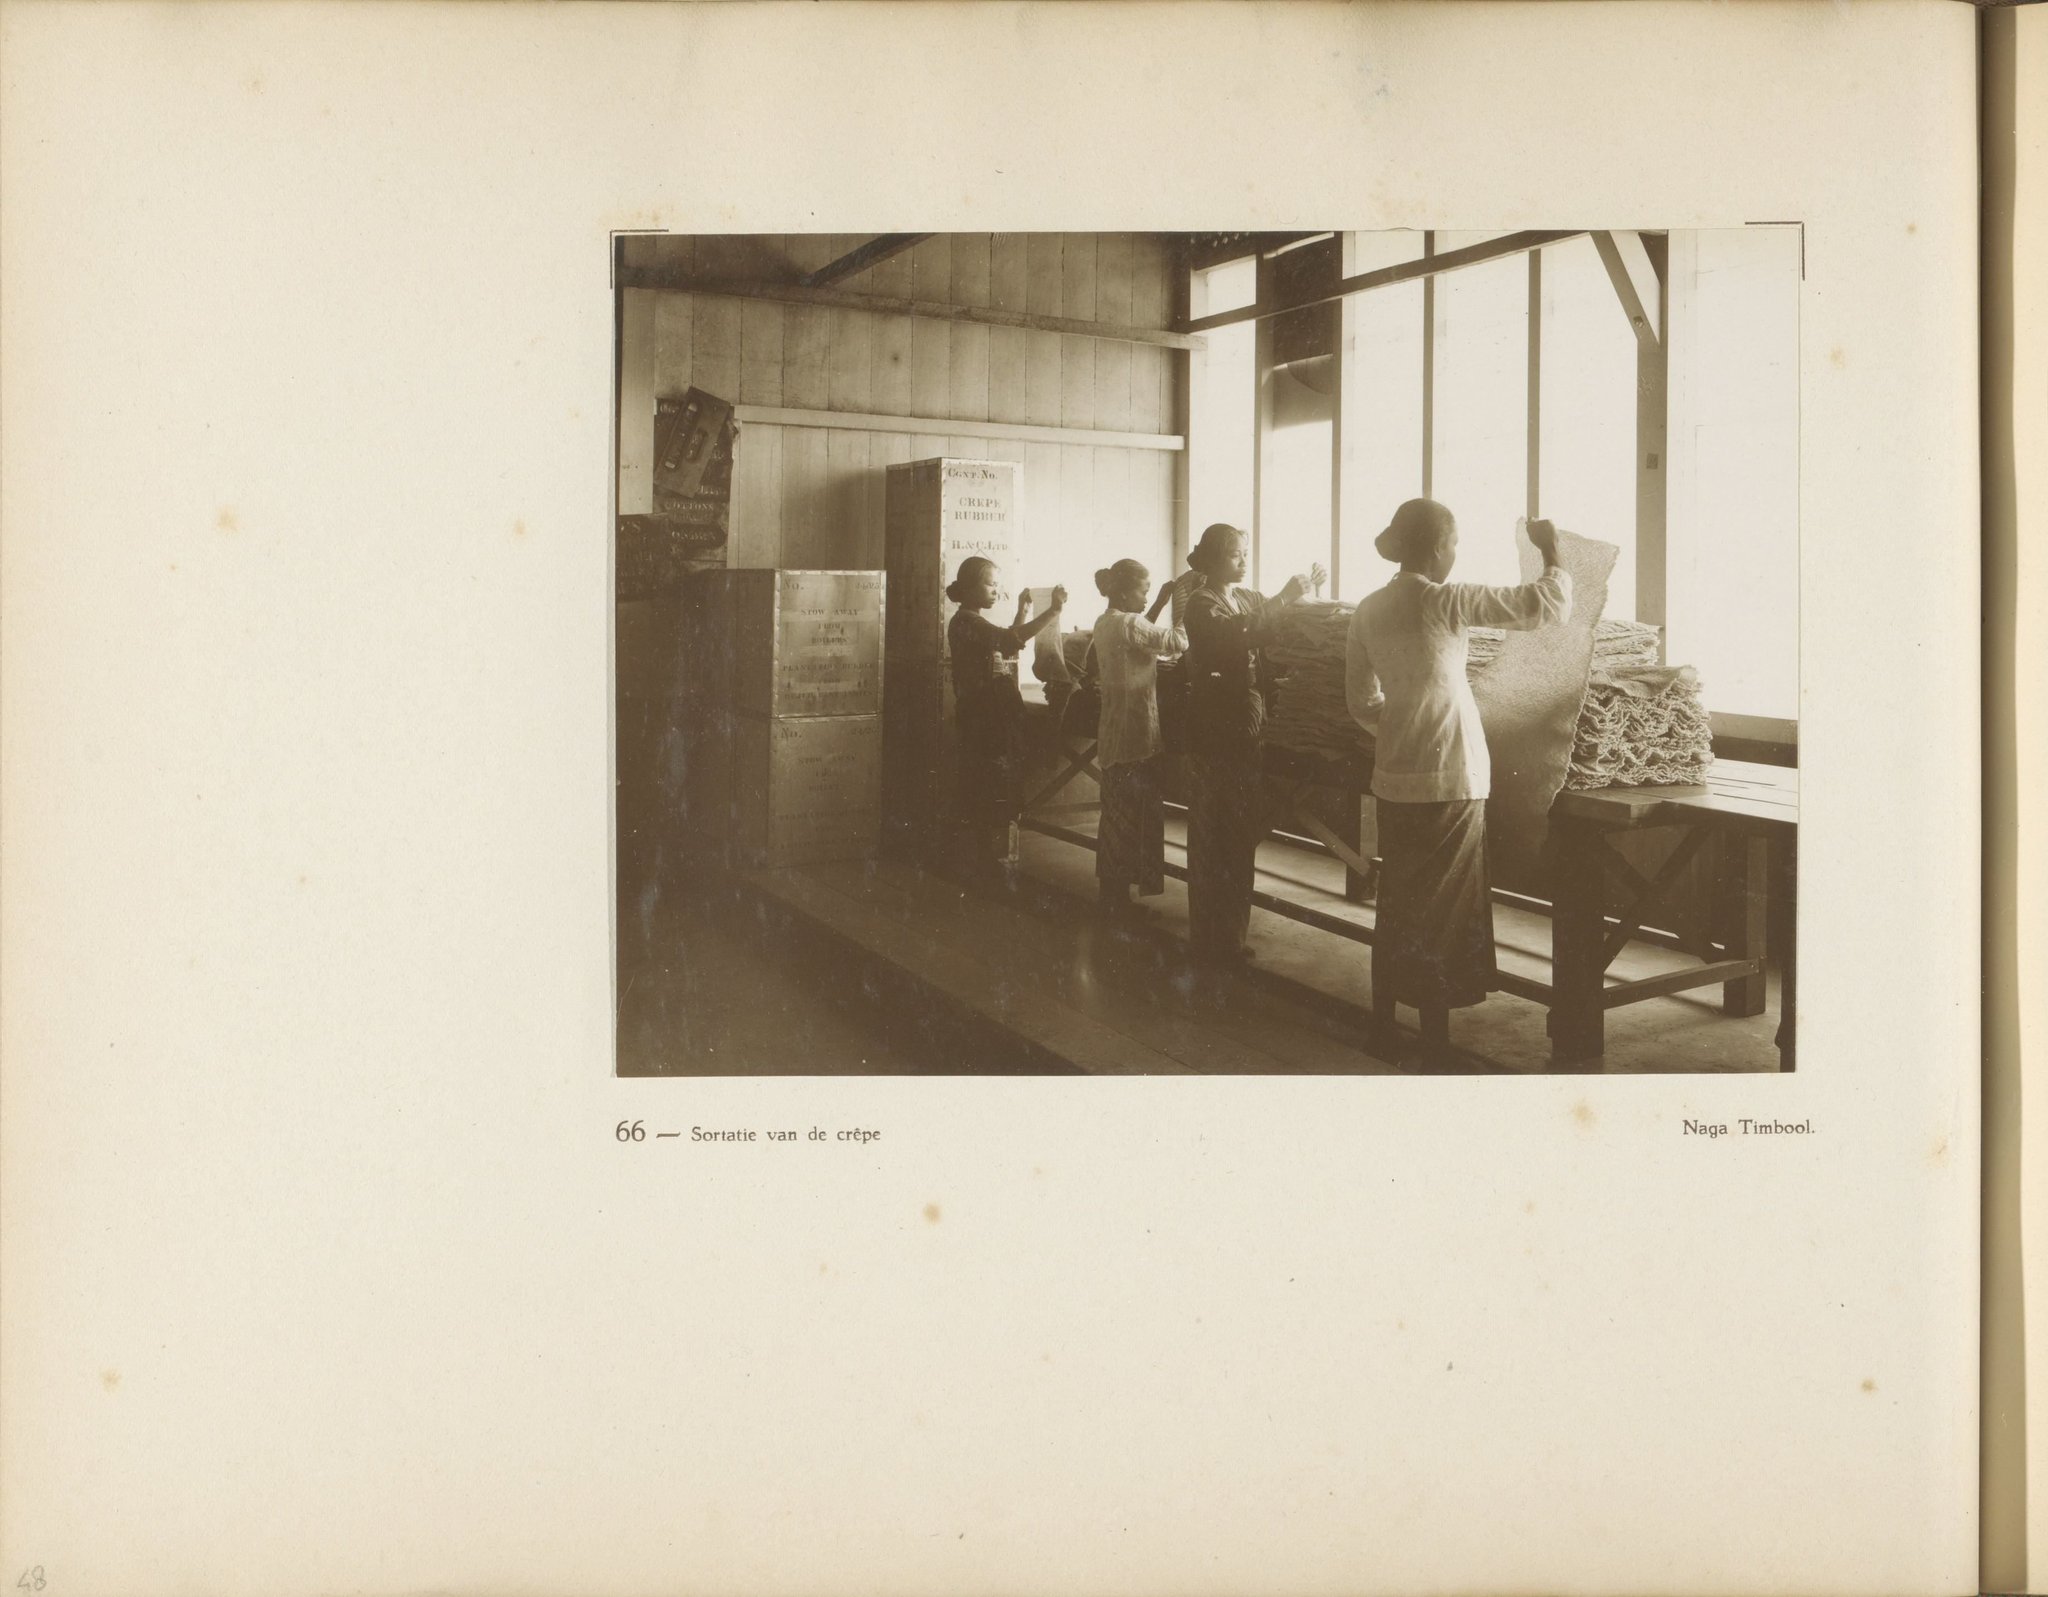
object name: album leaf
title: Pagina 66 van fotoboek van de Algemeene Vereeniging van Rubberplanters ter Oostkust van Sumatra (A.V.R.O.S.)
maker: j.w. meyster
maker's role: fotograaf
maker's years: 1887-1945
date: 1924-1925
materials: paper, photographic support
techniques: printing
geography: sumatra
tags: factory-interior, machine shop, (non-fruit) products of plants or trees: rubber, working class, labourers - aa - women, sumatra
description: Boekpagina met een foto van Indische vrouwen die rubbervellen ('crêpe') sorteren in een rubberfabriek van de Algemeene Vereeniging van Rubberplanters ter Oostkust van Sumatra (A.V.R.O.S.) te Naga Timbool. Onderdeel van een fotoboek van de Algemeene Vereeniging van Rubberplanters ter Oostkust van Sumatra (A.V.R.O.S.).